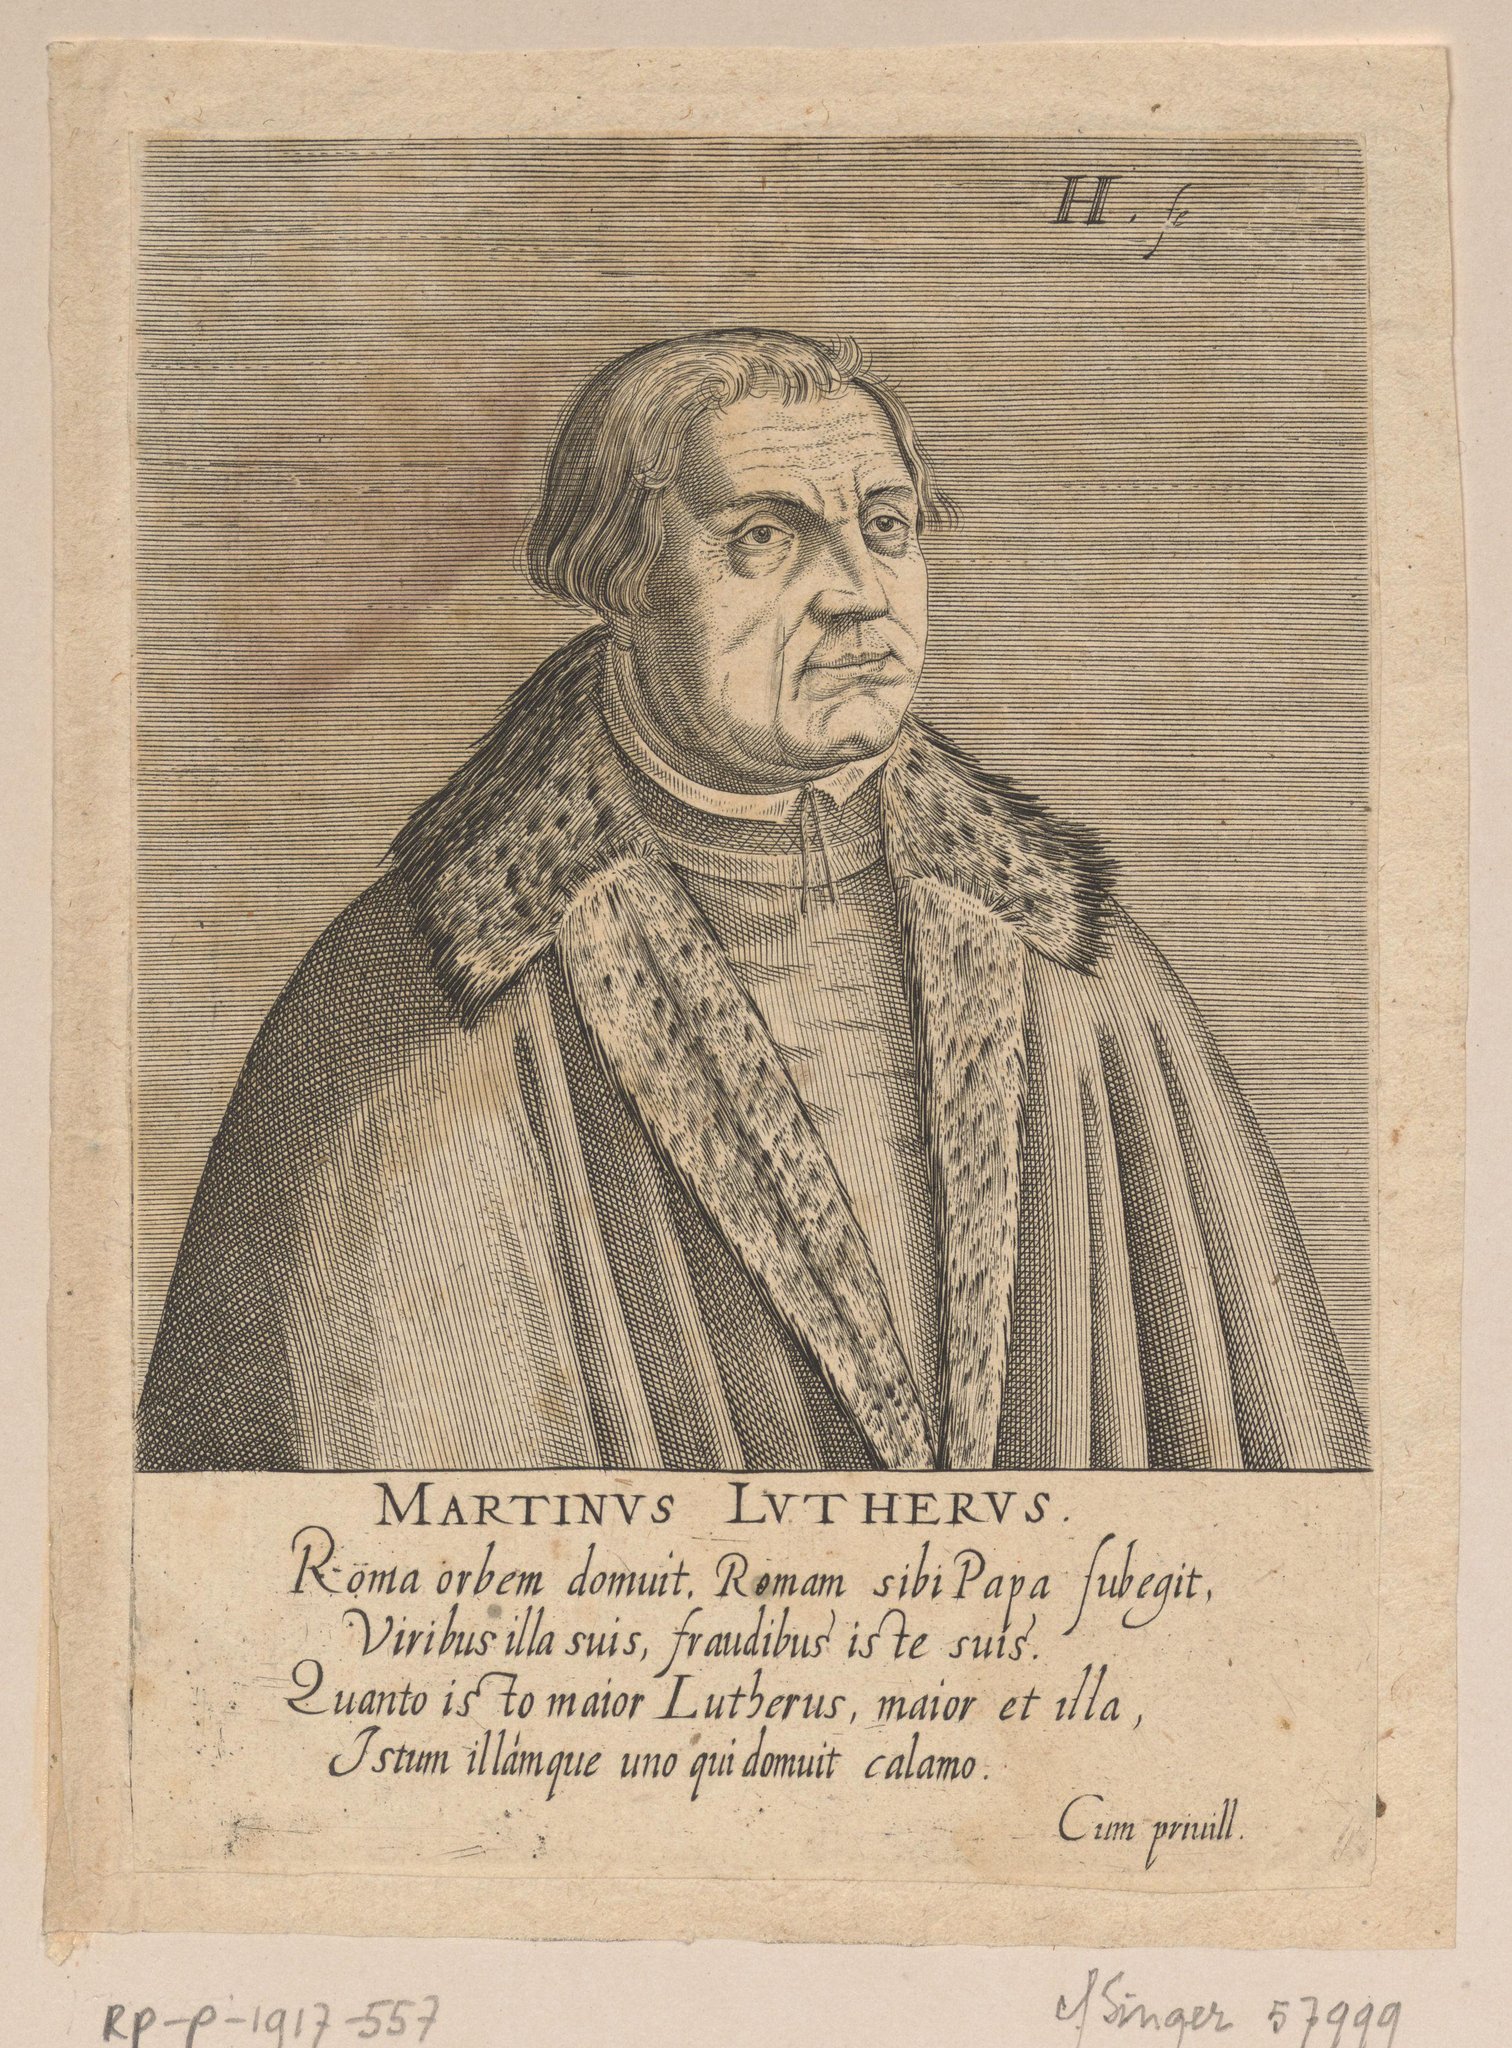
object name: print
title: Icones virorum nostra patrumq. memoria illustrium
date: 1599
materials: paper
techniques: engraving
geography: the hague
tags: priest, martin luther, theologian, historical persons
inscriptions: collector's mark: Lugt 2228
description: De prent is later, met tekst in boekdruk op verso, nog gebruikt in publicaties uit 1603 en 1604.